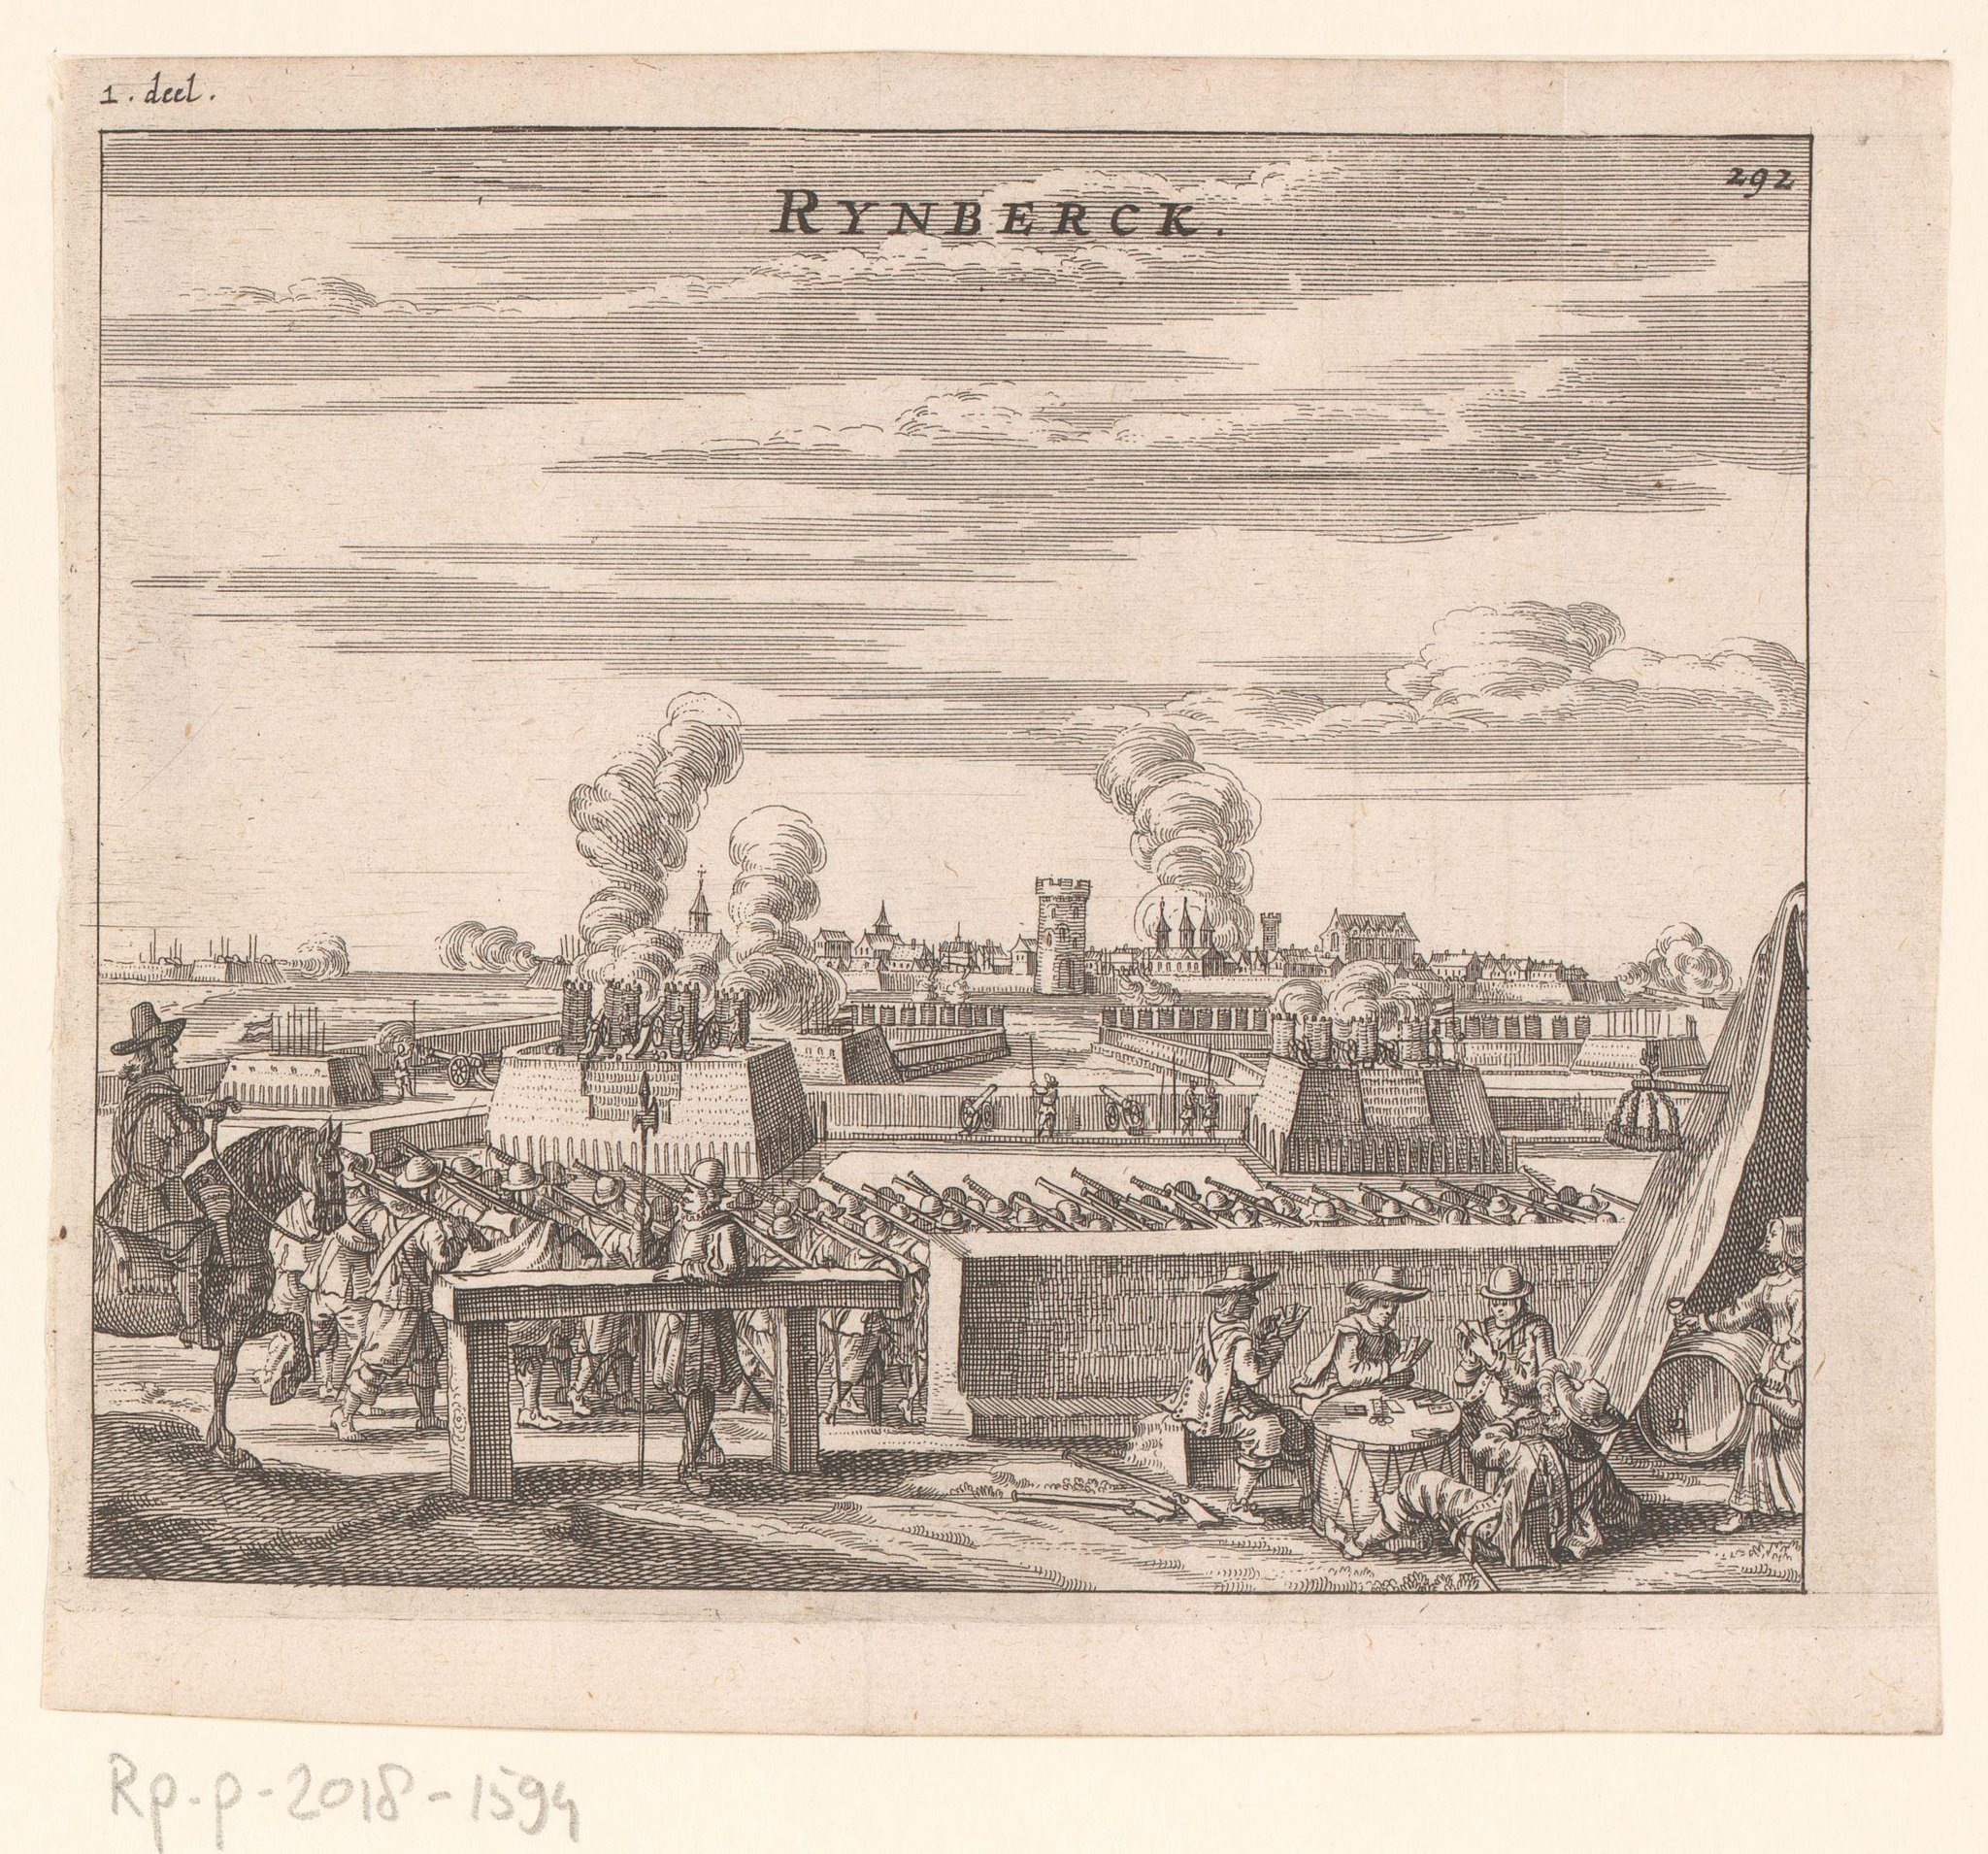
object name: print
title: Beleg van Rheinberg, waarschijnlijk 1597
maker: Anonymous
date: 1625-1699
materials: paper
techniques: etching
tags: siege, position war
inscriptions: collector's mark: Lugt 2228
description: Waarschijnlijk de belegering en inname van de stad Coevorden door het leger van Maurits in 1597. Rechtsvoor een groep kaartende soldaten. Linksboven gemerkt: 1 deel. Rechtsboven genummerd: 292.